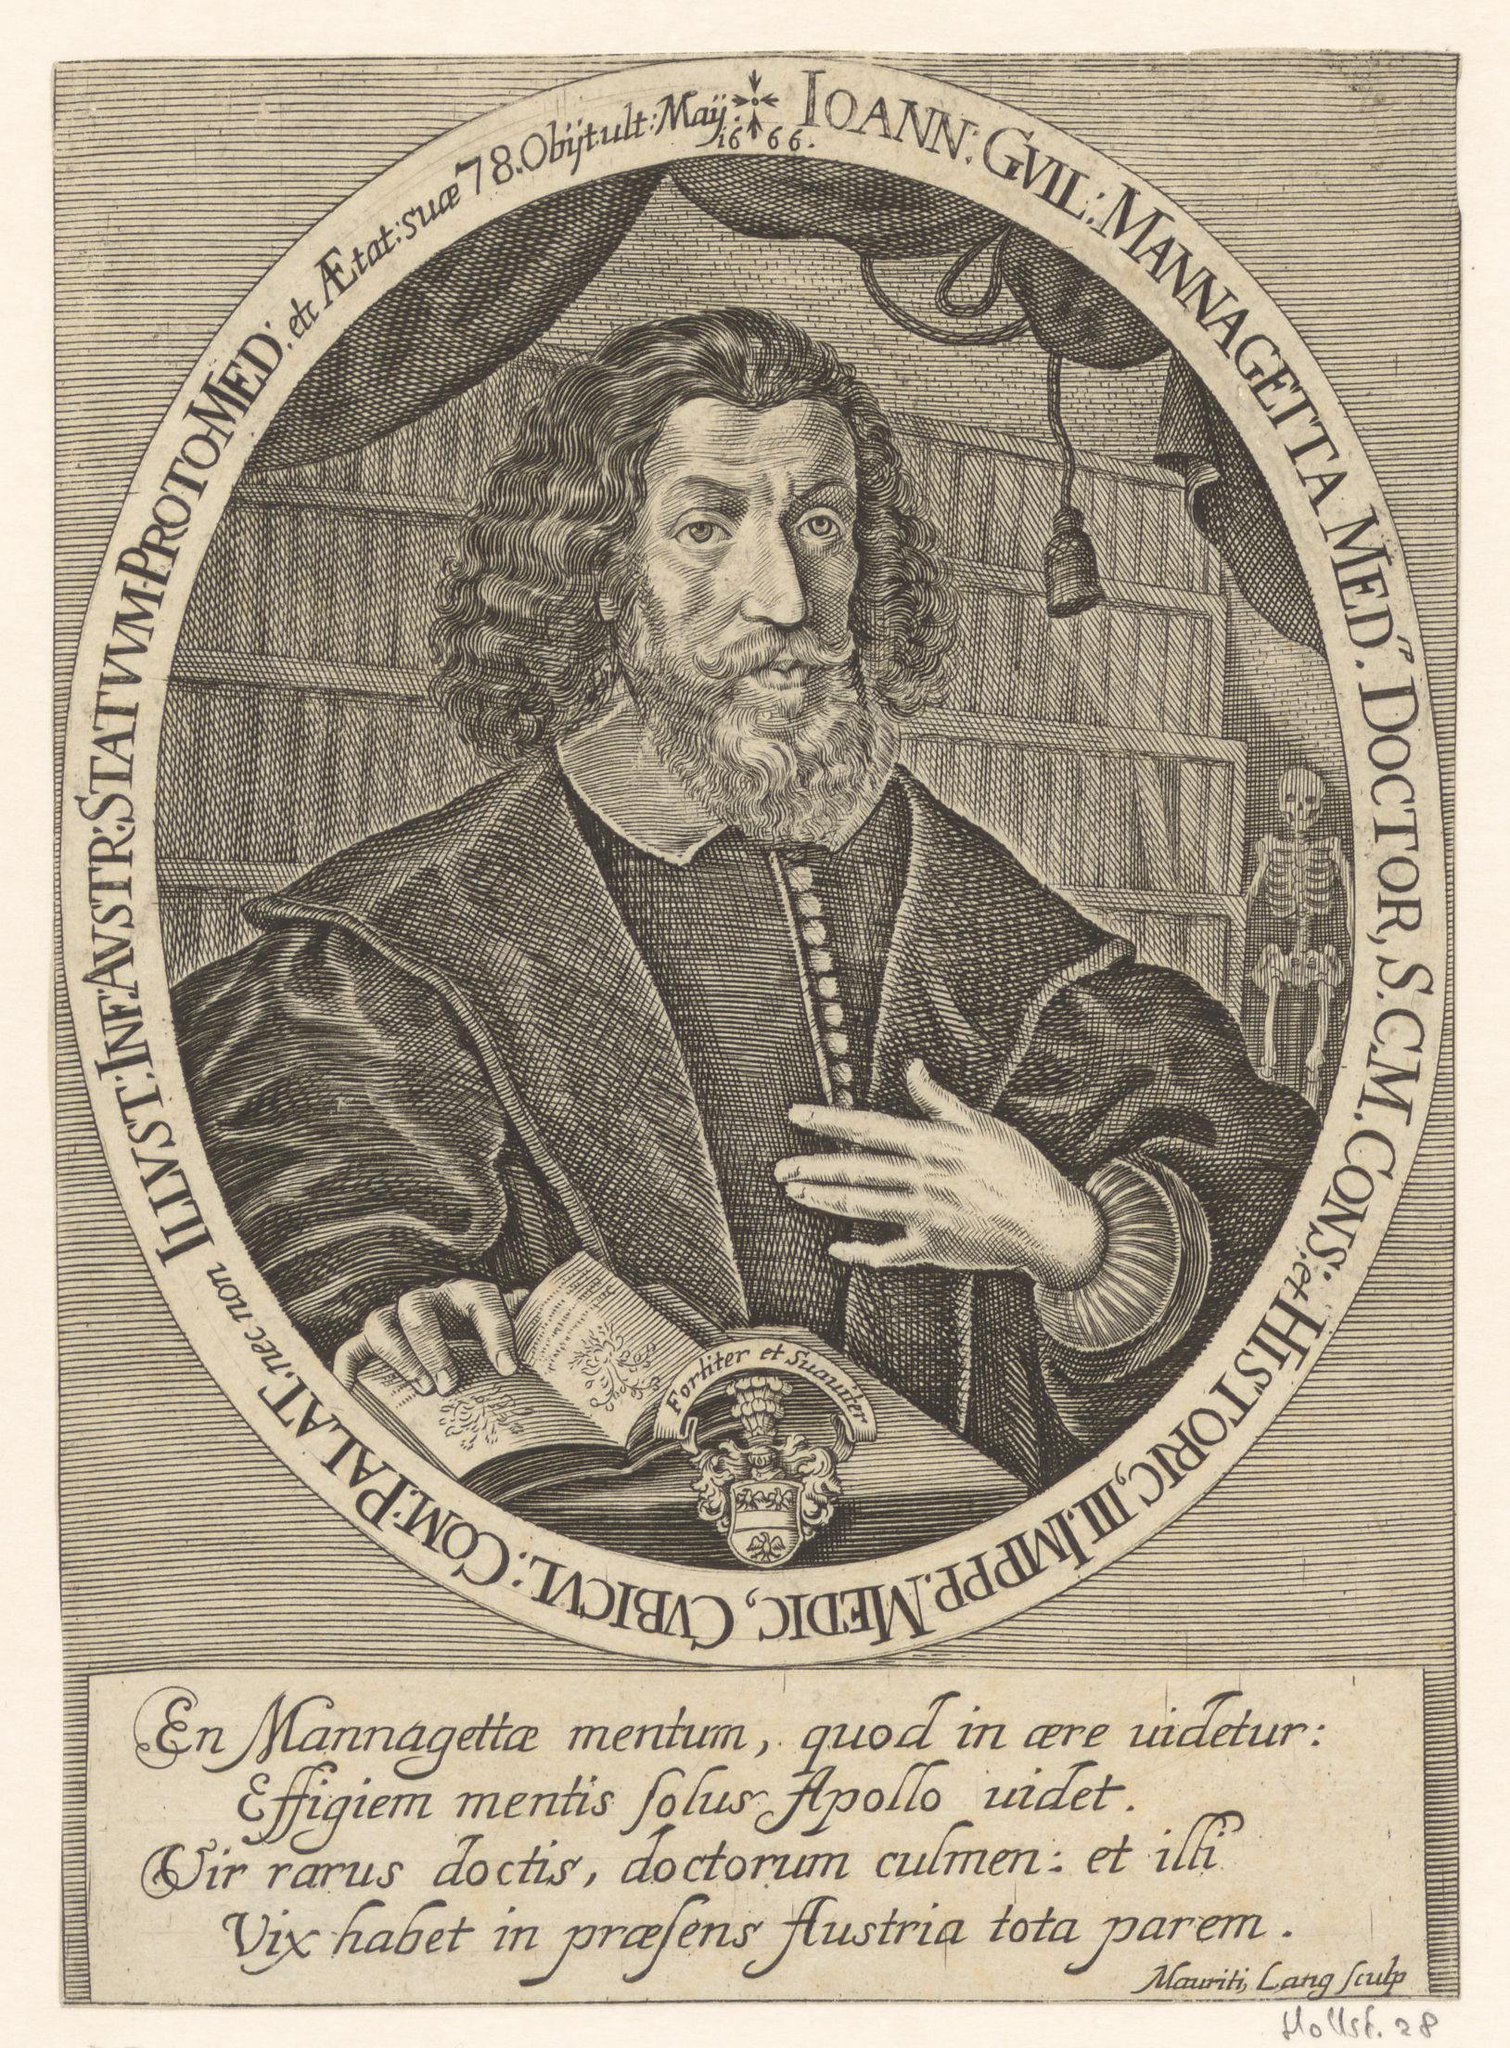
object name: print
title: Portret van Johann Wilhelm Mannagetta op 78-jarige leeftijd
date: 1666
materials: paper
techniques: engraving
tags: historical persons, (human) skeleton, physician, doctor (+ portrait of scholar, scientist)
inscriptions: collector's mark: Lugt 2228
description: Tekst in het Latijn in de omlijsting en in de ondermarge.